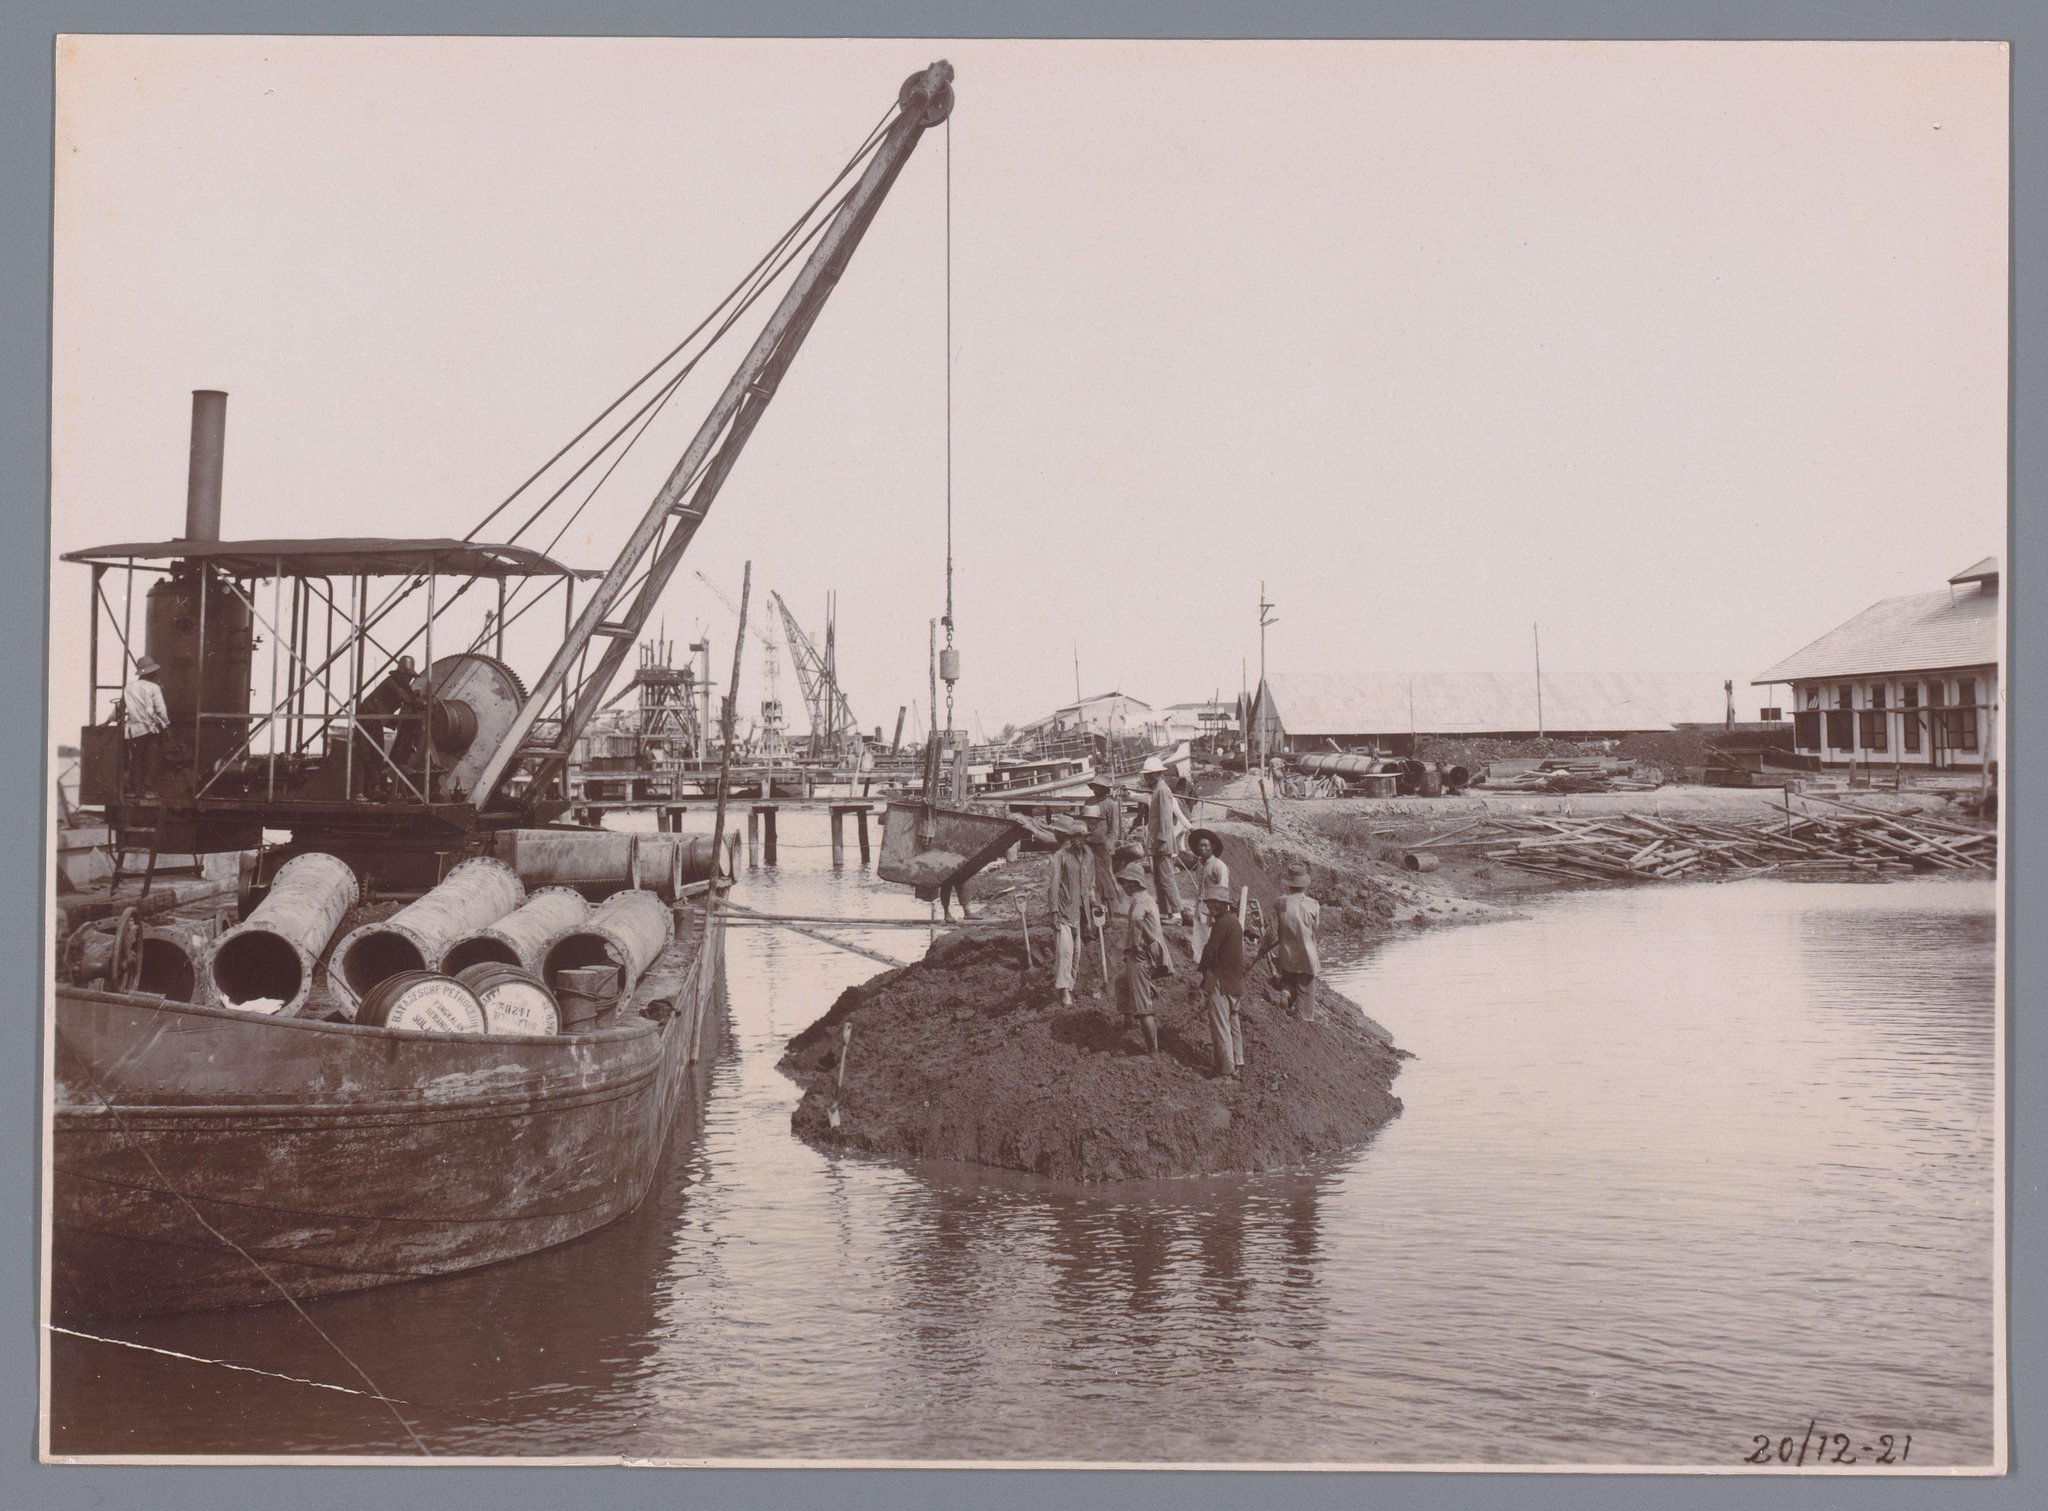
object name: photograph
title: Dichten afsluitdam Bouwput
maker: Anonymous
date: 1921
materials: photographic support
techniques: gelatin silver print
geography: belawan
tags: harbour, building-site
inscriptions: date: ‘20/12-21’, inscription: ‘No. 102 Dichten afsluitdam Bouwput’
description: Het dichten van de dam om de bouwput. Genummerd: 102. Onderdeel van de groep van losse foto's over de aanleg van de haven Belawan aan de kust voor Medan, Sumatra 1921-1922.